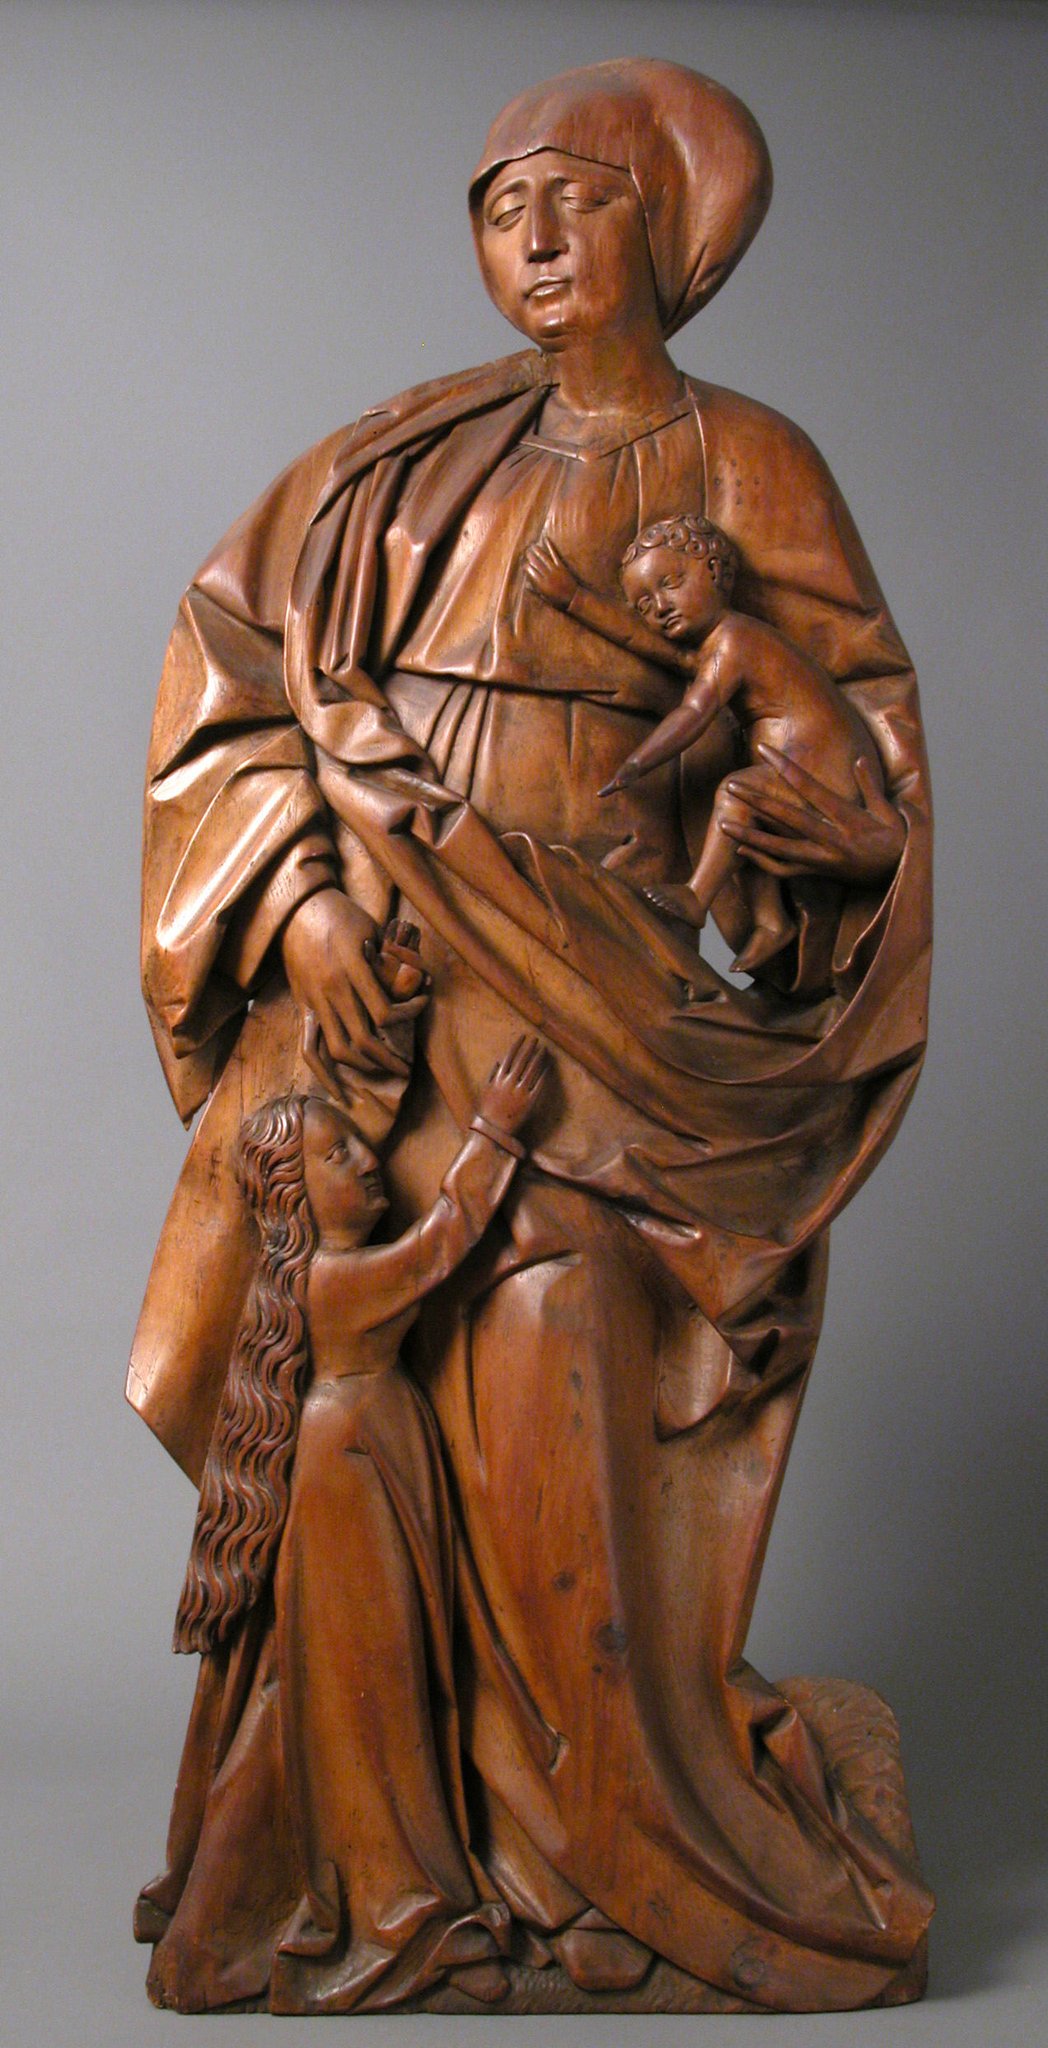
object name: relief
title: Saint Anne with the Virgin and Child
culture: german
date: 1520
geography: germany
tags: madonna and child